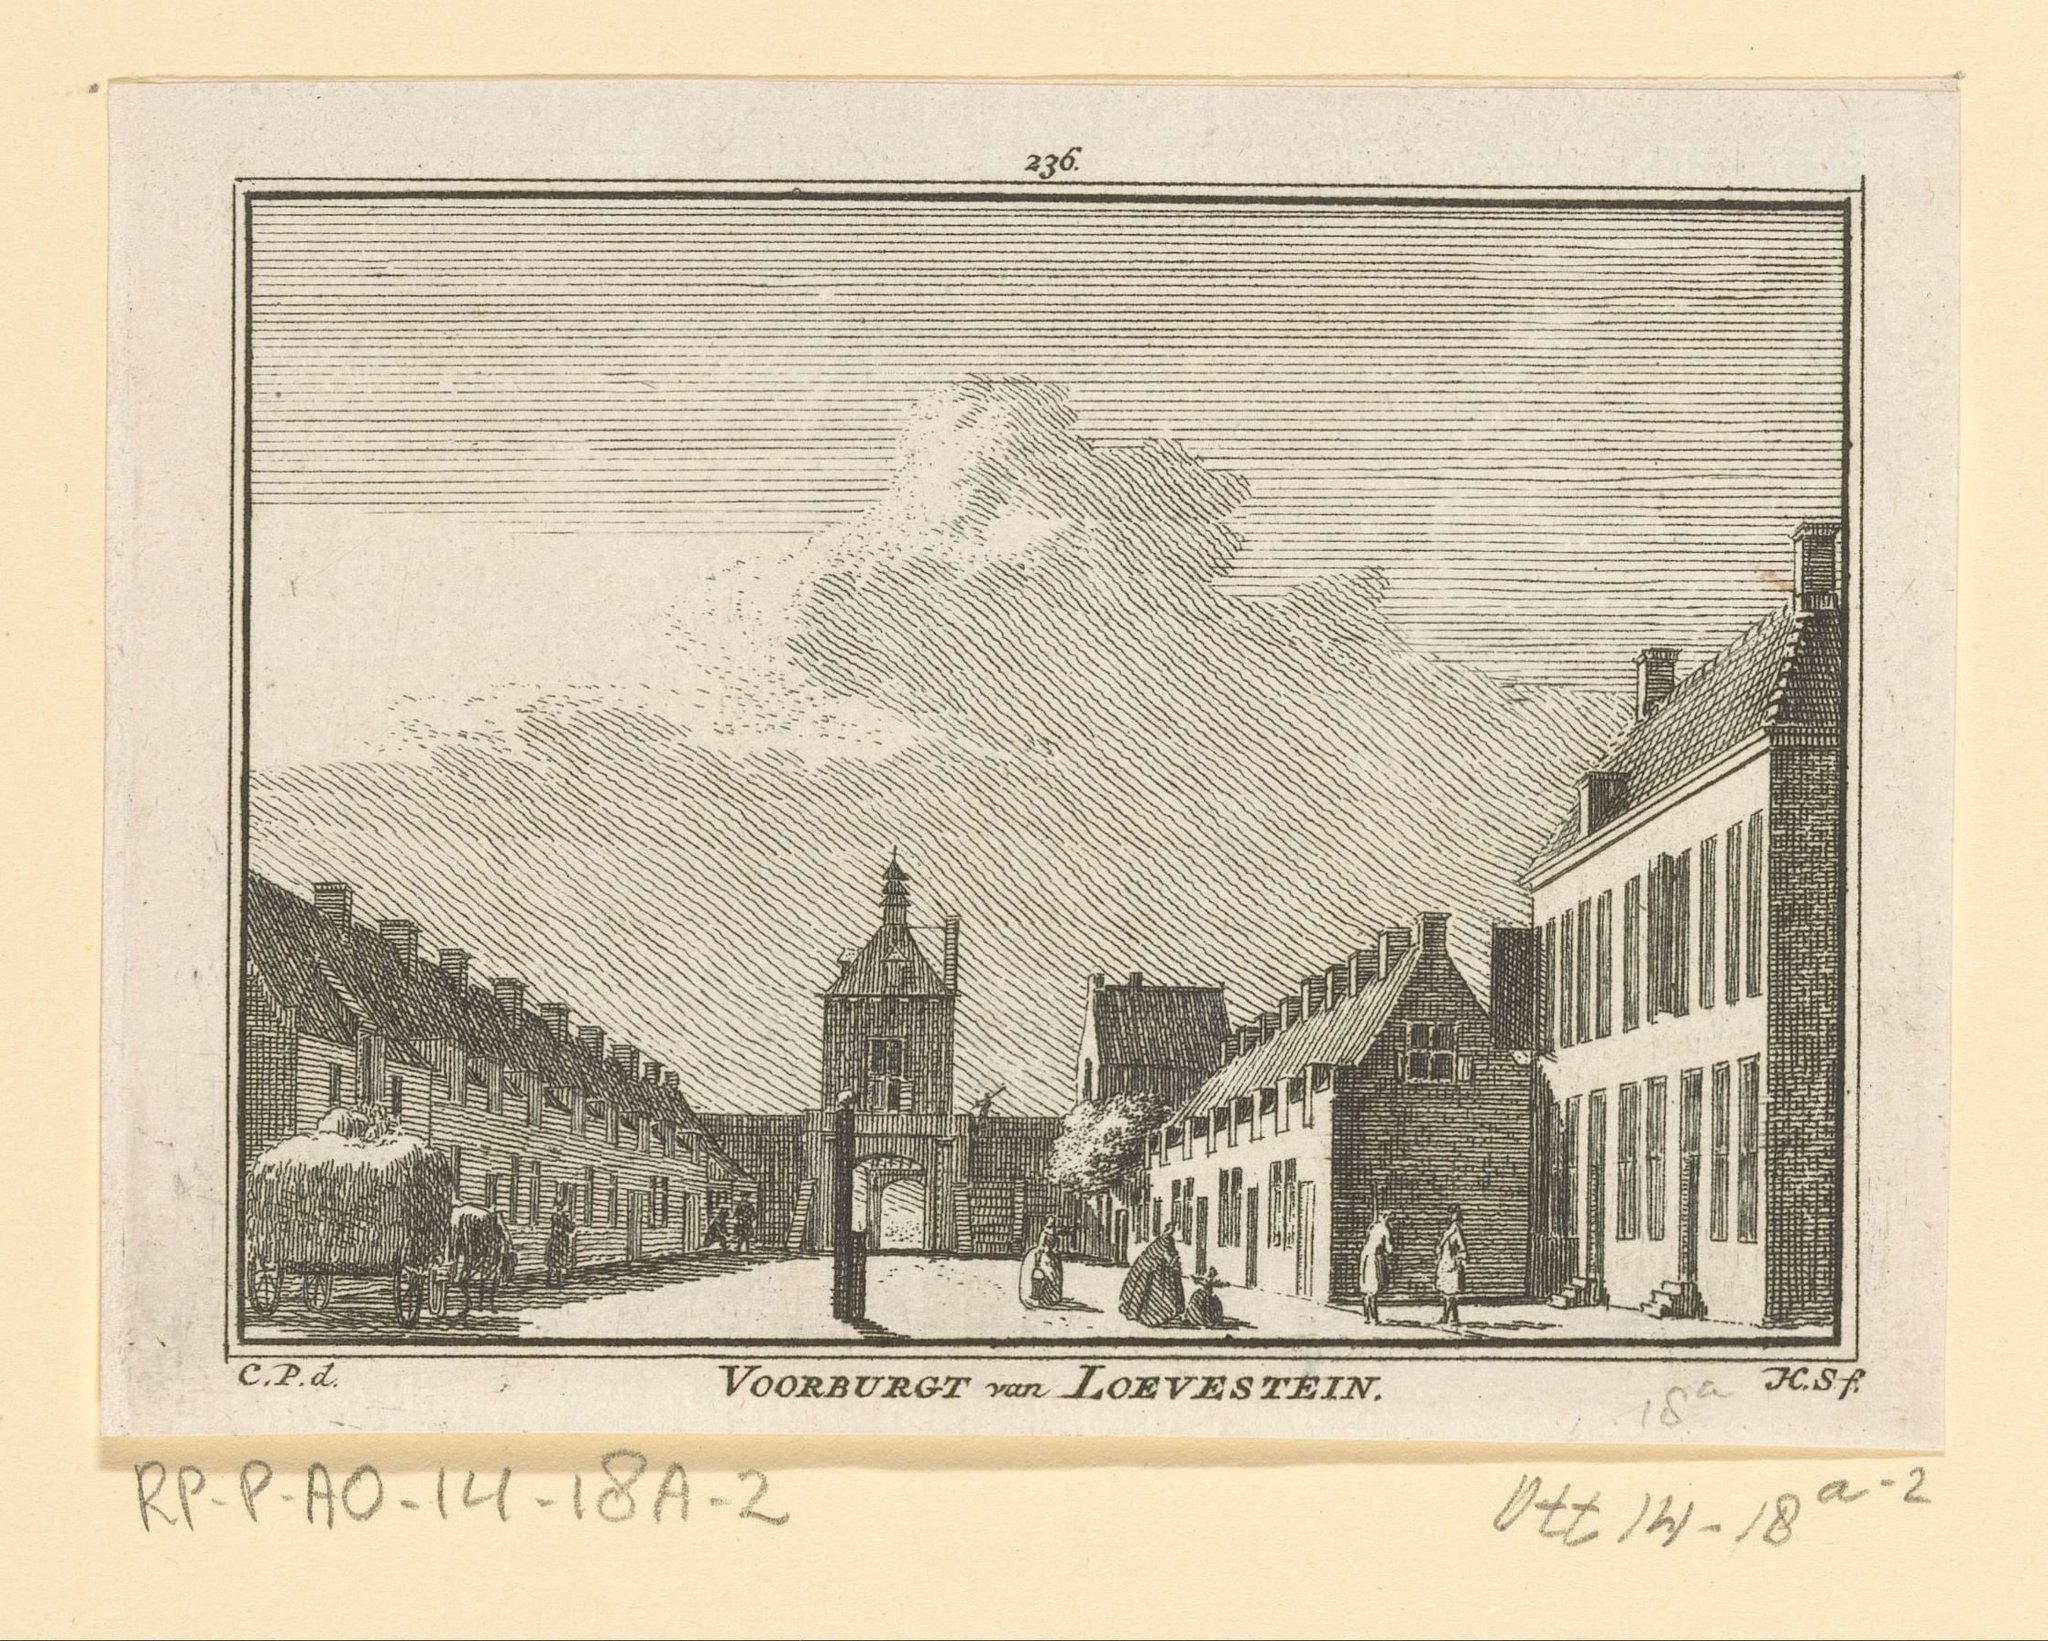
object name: book illustration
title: Gezicht op de voorburcht van Slot Loevestein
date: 1750-1792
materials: paper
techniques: etching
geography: haarlem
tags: castle, loevestein castle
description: Prent ook gebruikt in: Het verheerlykt Nederland of kabinet van hedendaagsche gezigten van steden, dorpen (…). 9 delen. Amsterdam: Isaak Tirion en weduwe Isaak Tirion, 1745-1774, dl. 3 (1750), ill. 236. Of in: Nederlandsche tafereelen; of eene keurige verzameling van negen honderd fraaije gezigten van steden, dorpen, sloten, oudheden (….). 9 delen. Amsterdam: Jan de Groot, 1792, dl. 3, ill. 236. Zie RP-T-1900-A-4353 voor de tekening waar deze prent op is gebaseerd.